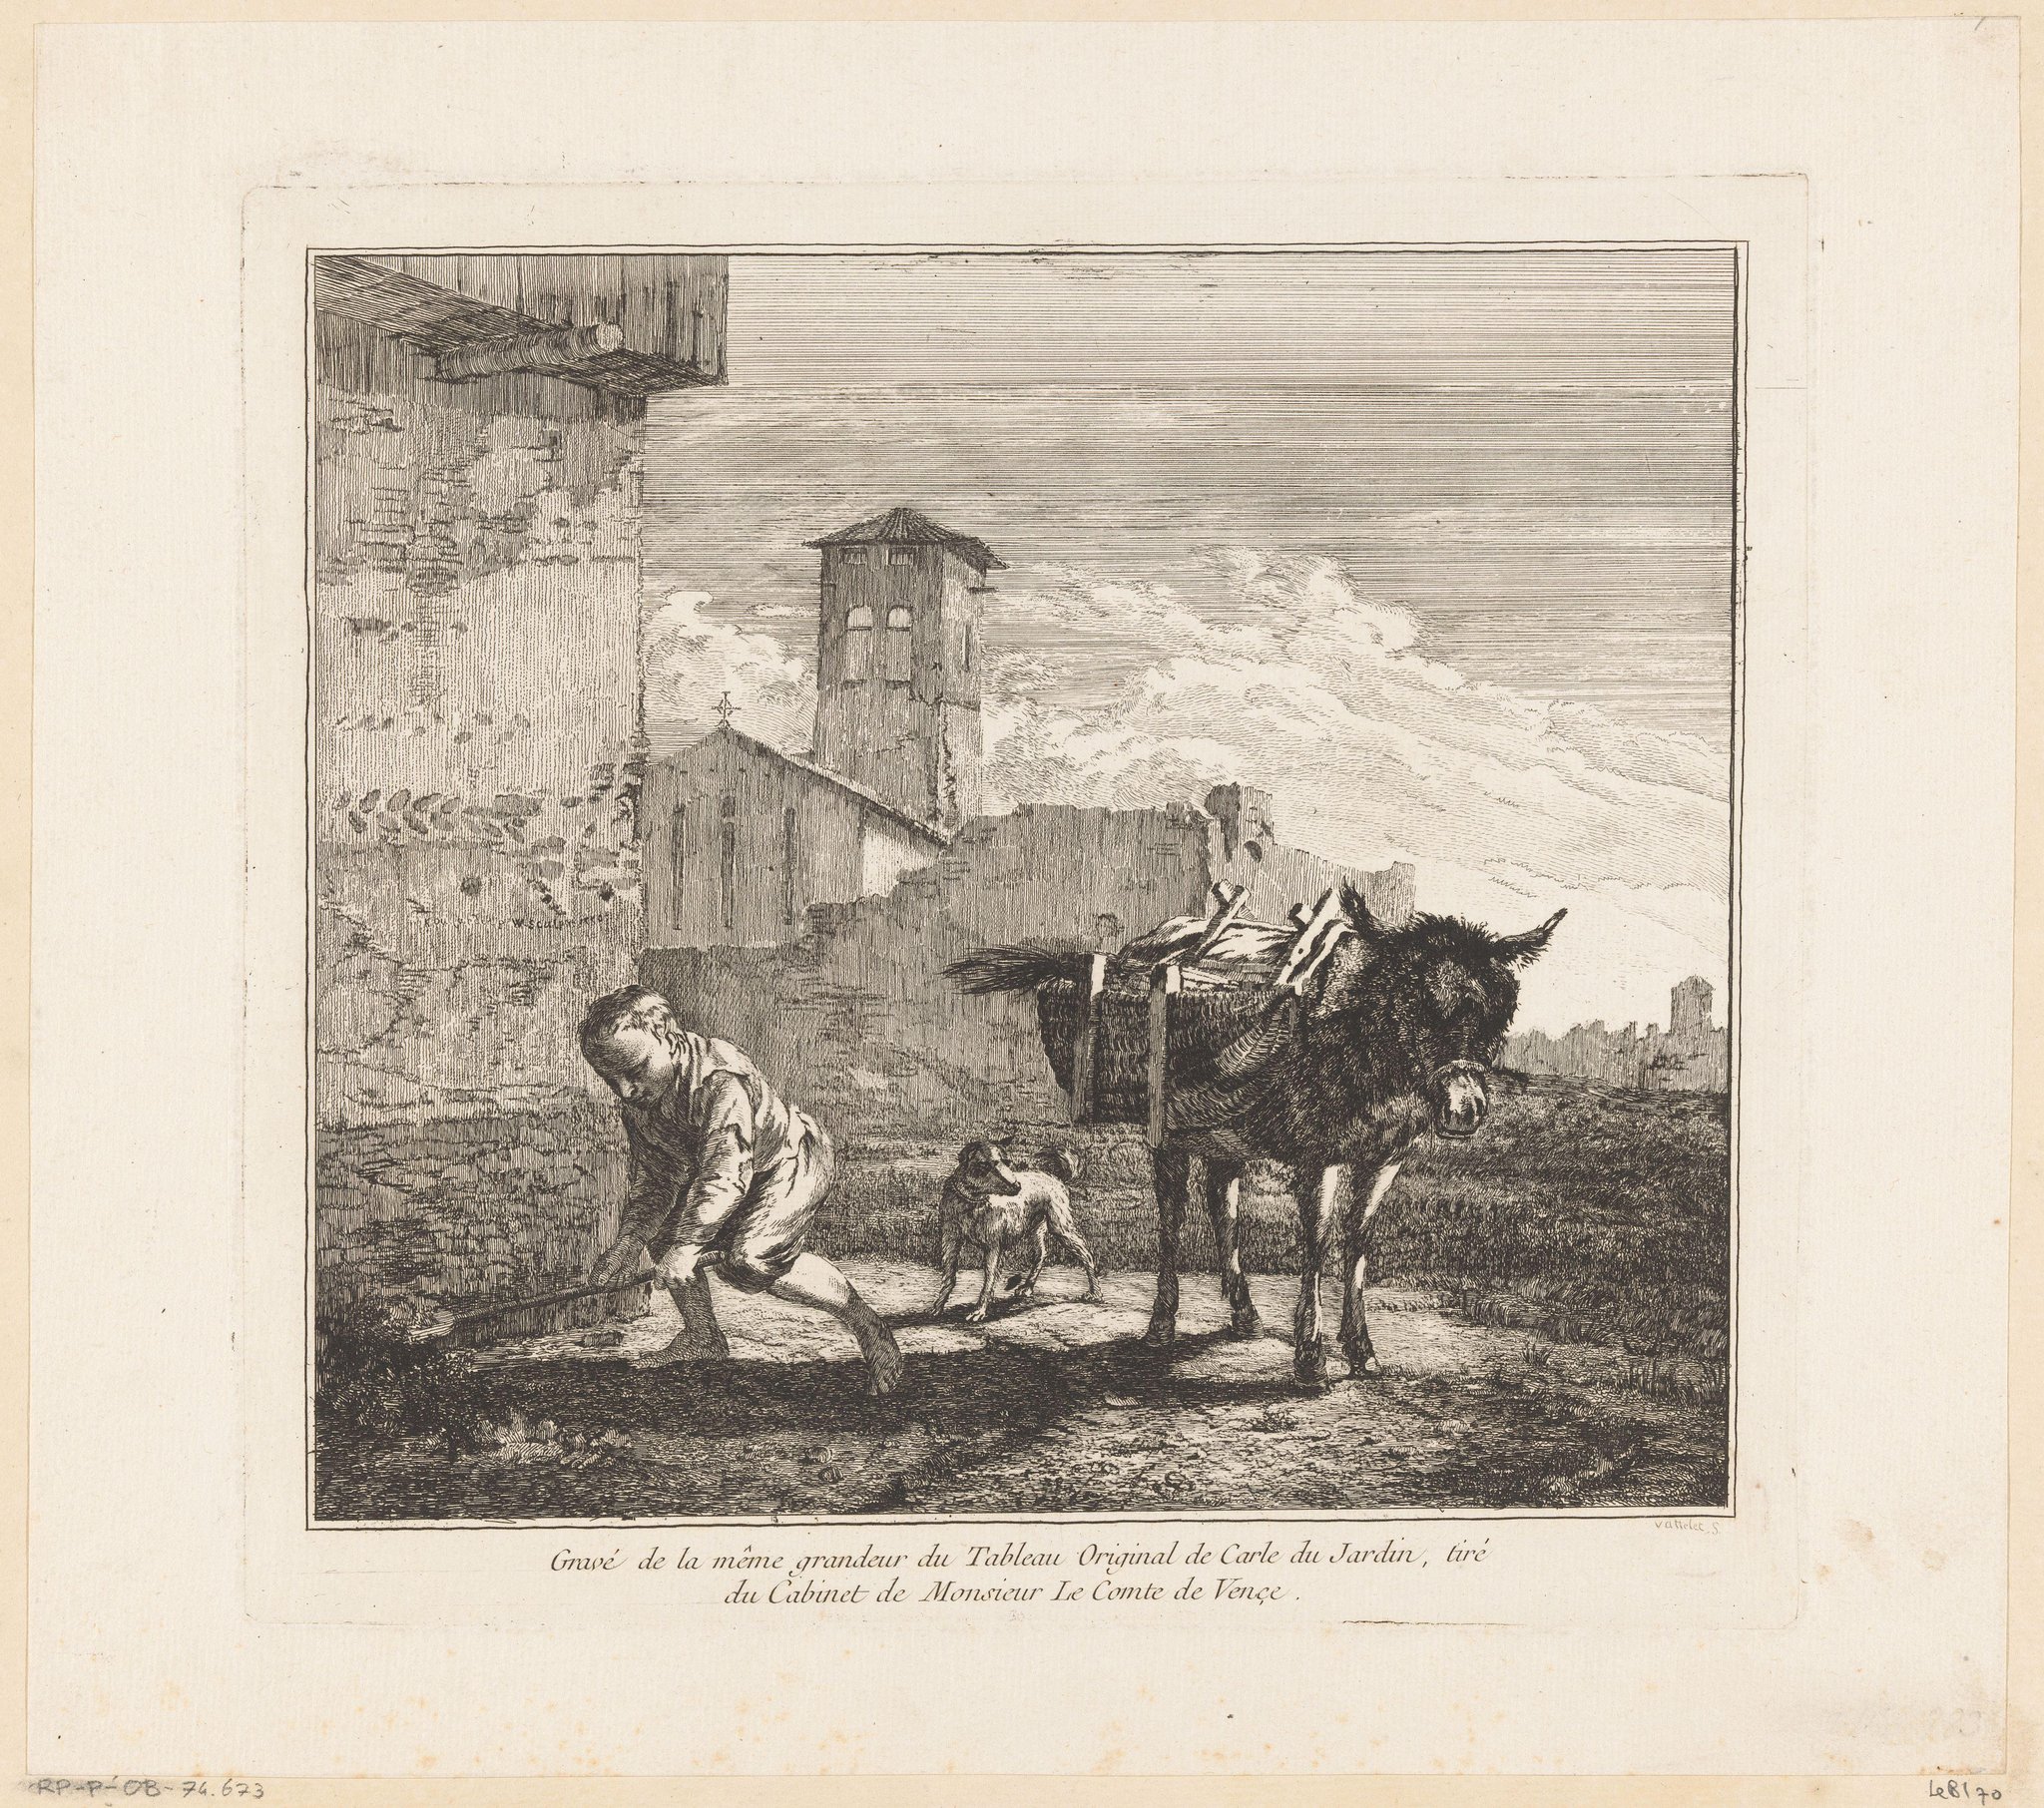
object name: print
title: Landschap met ruïne en jonge ezeldrijver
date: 1728-1786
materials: paper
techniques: etching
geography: france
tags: boy (child between toddler and youth), animal mounts; pack-animals, landscape with ruins - ii - ideal landscapes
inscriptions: collector's mark: Lugt 240